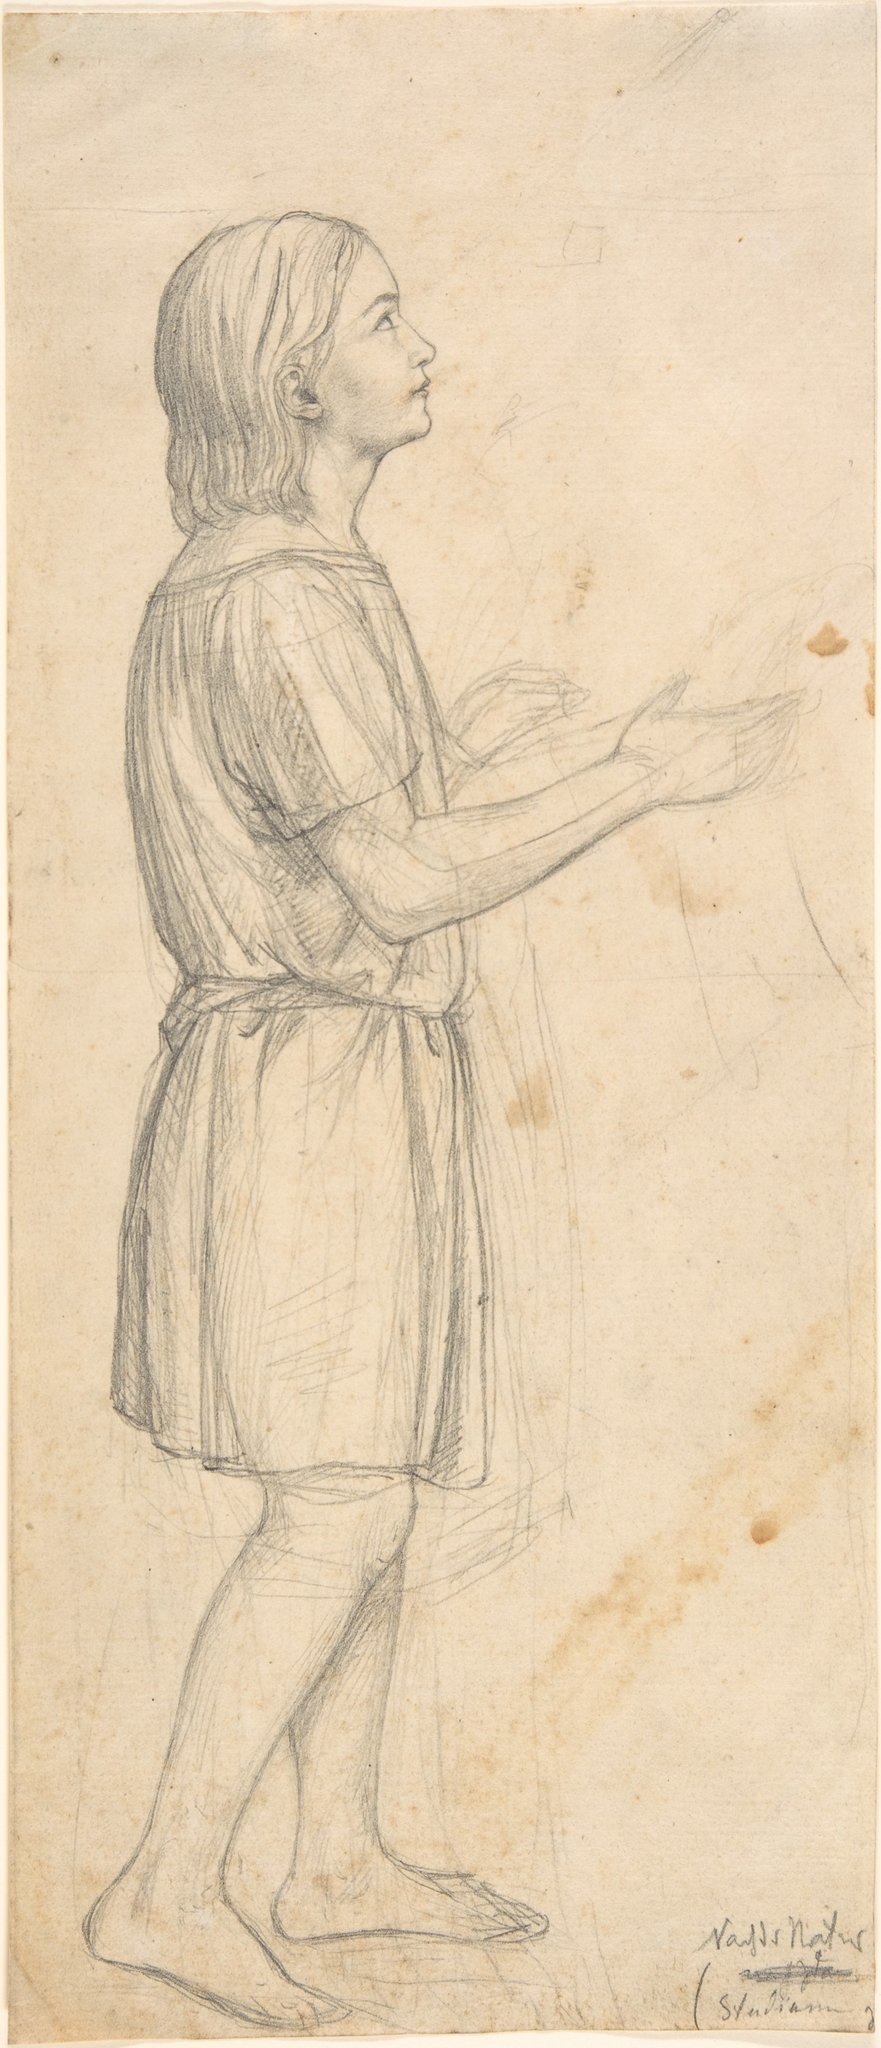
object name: drawing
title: Standing Youth, Looking Up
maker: otto speckter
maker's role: artist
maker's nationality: german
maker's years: 1807-1871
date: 1820-1871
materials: pencil, paper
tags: girls